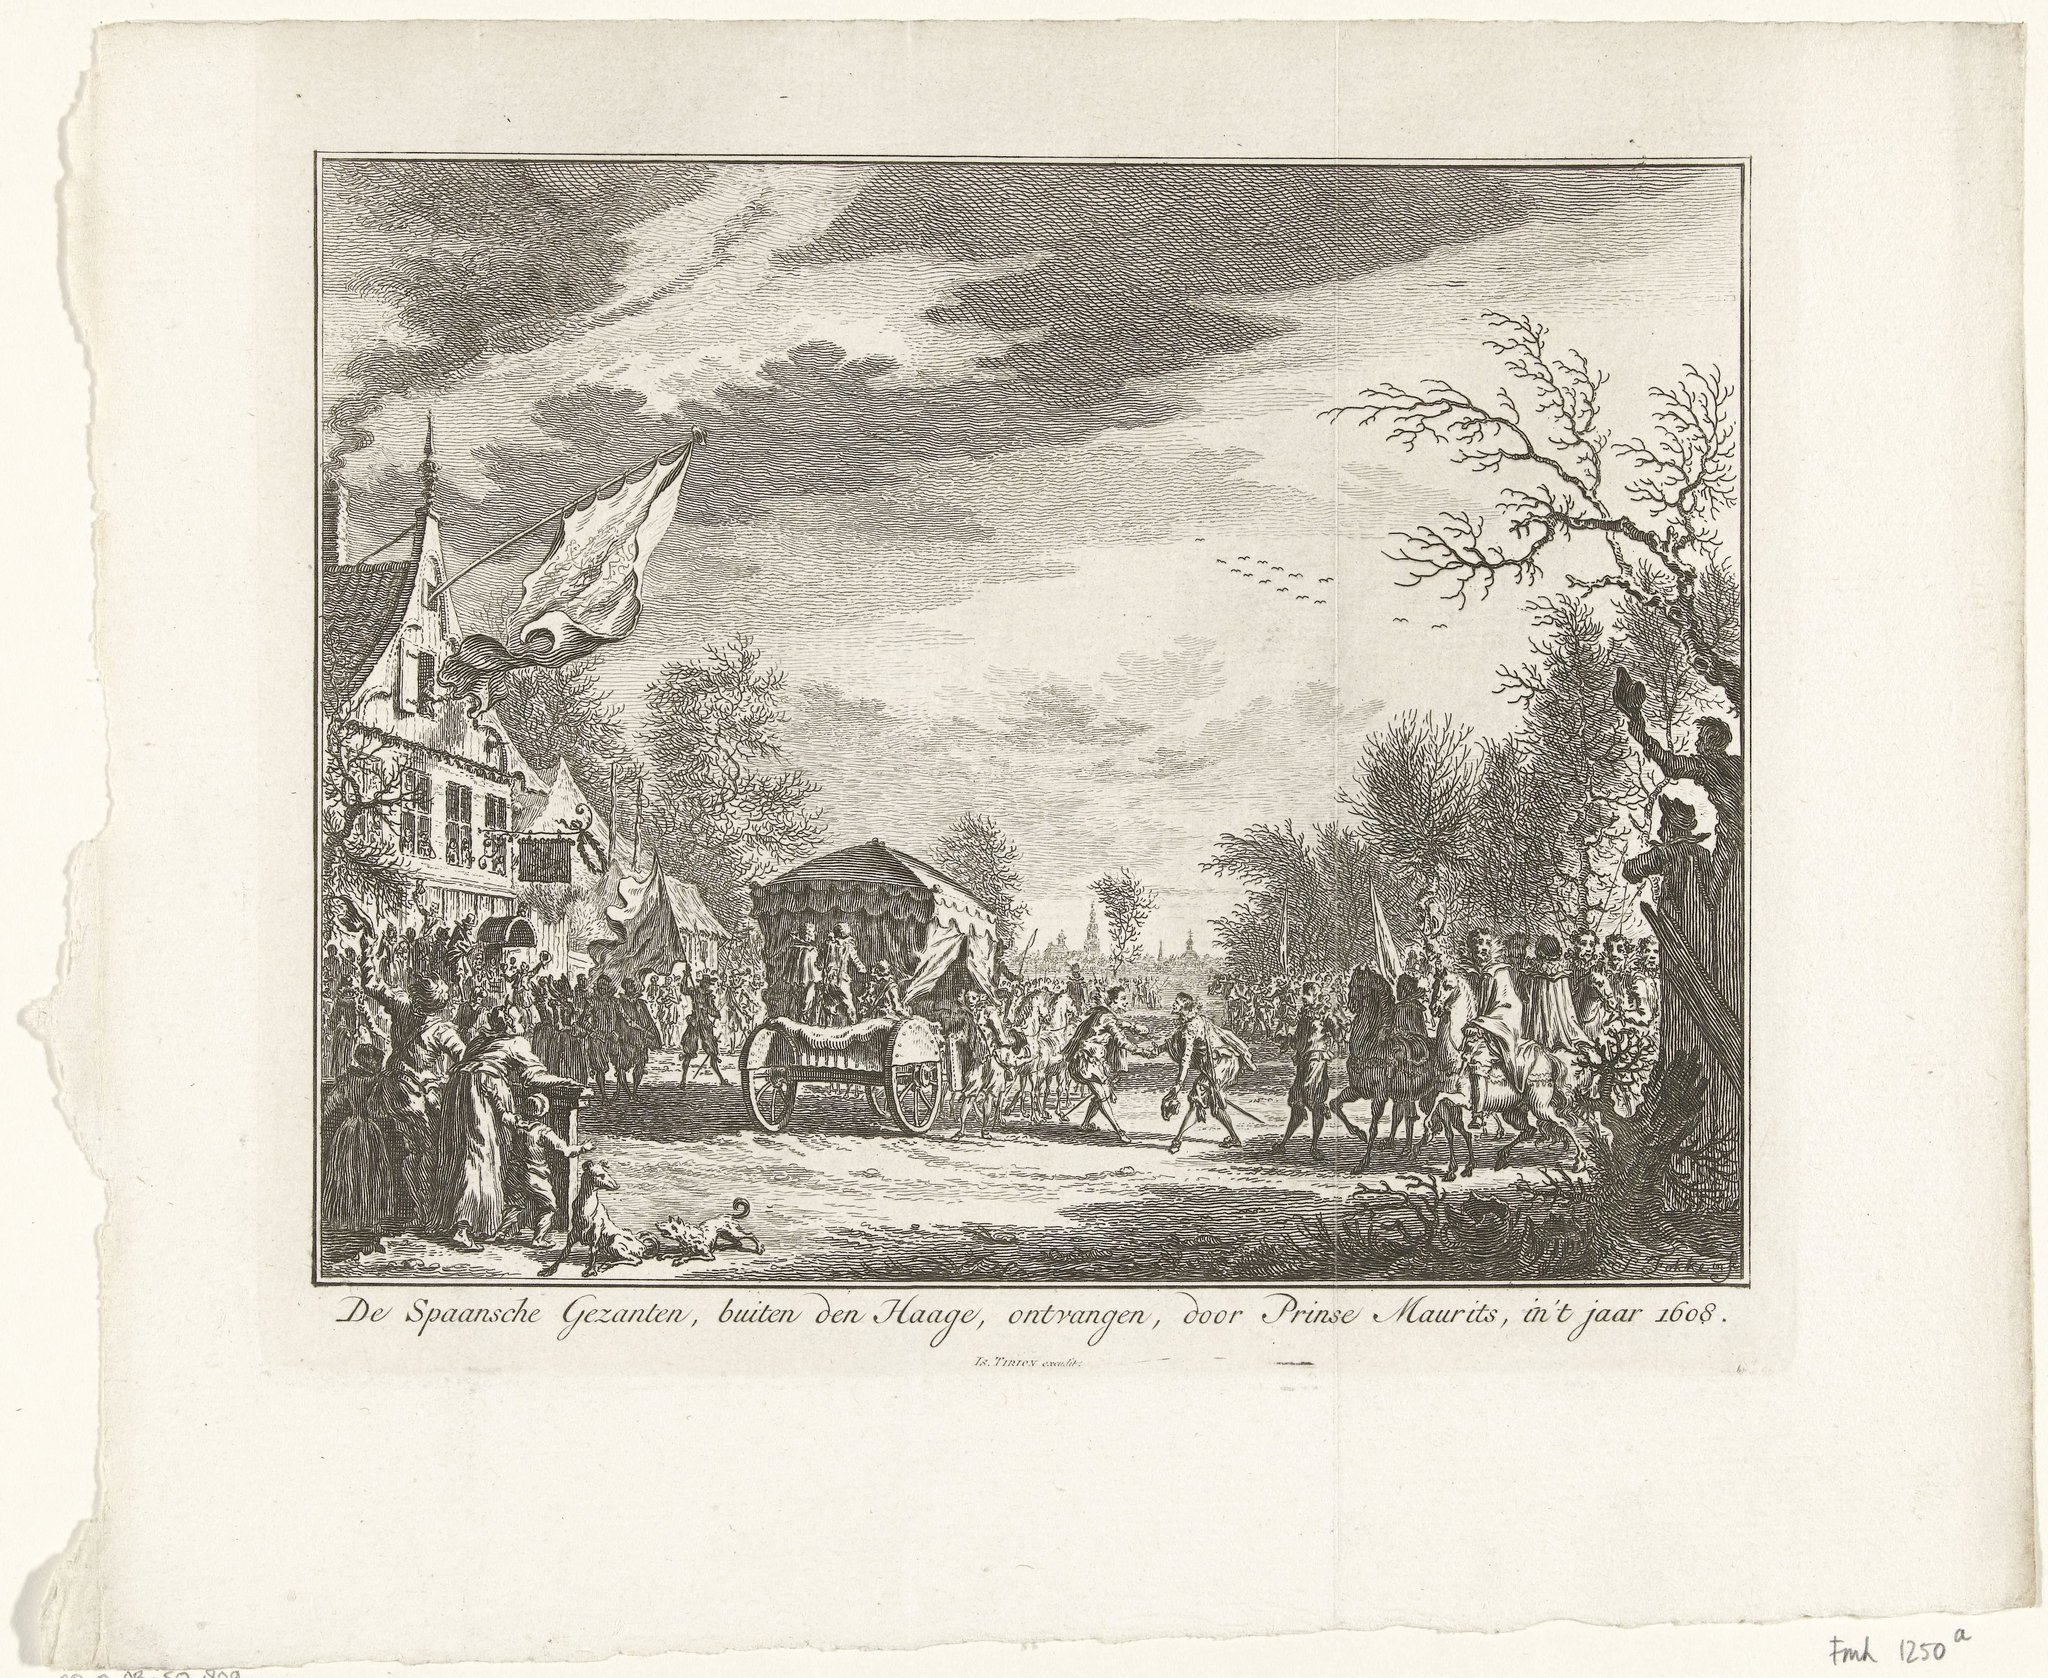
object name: print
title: De Spaansche Gezanten, buiten den Haage, ontvangen, door Prinse Maurits, in 't jaar 1608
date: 1753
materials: paper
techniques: etching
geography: amsterdam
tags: maurice (prince of orange), peace negotiations, meeting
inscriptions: collector's mark: Lugt 2228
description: Aankomst en begroeting te Rijswijk van de Spaanse gezanten voor de vredesonderhandelingen, februari 1608. Maurits en Spinola geven elkaar de hand. Het rijtuig is gestopt voor een herberg waar veel toeschouwers staan.